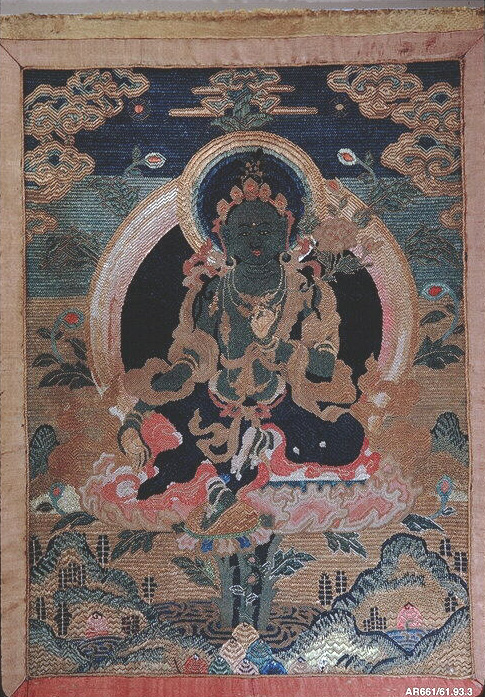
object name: banner panel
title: Panel from Banner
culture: chinese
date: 1368-1644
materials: silk